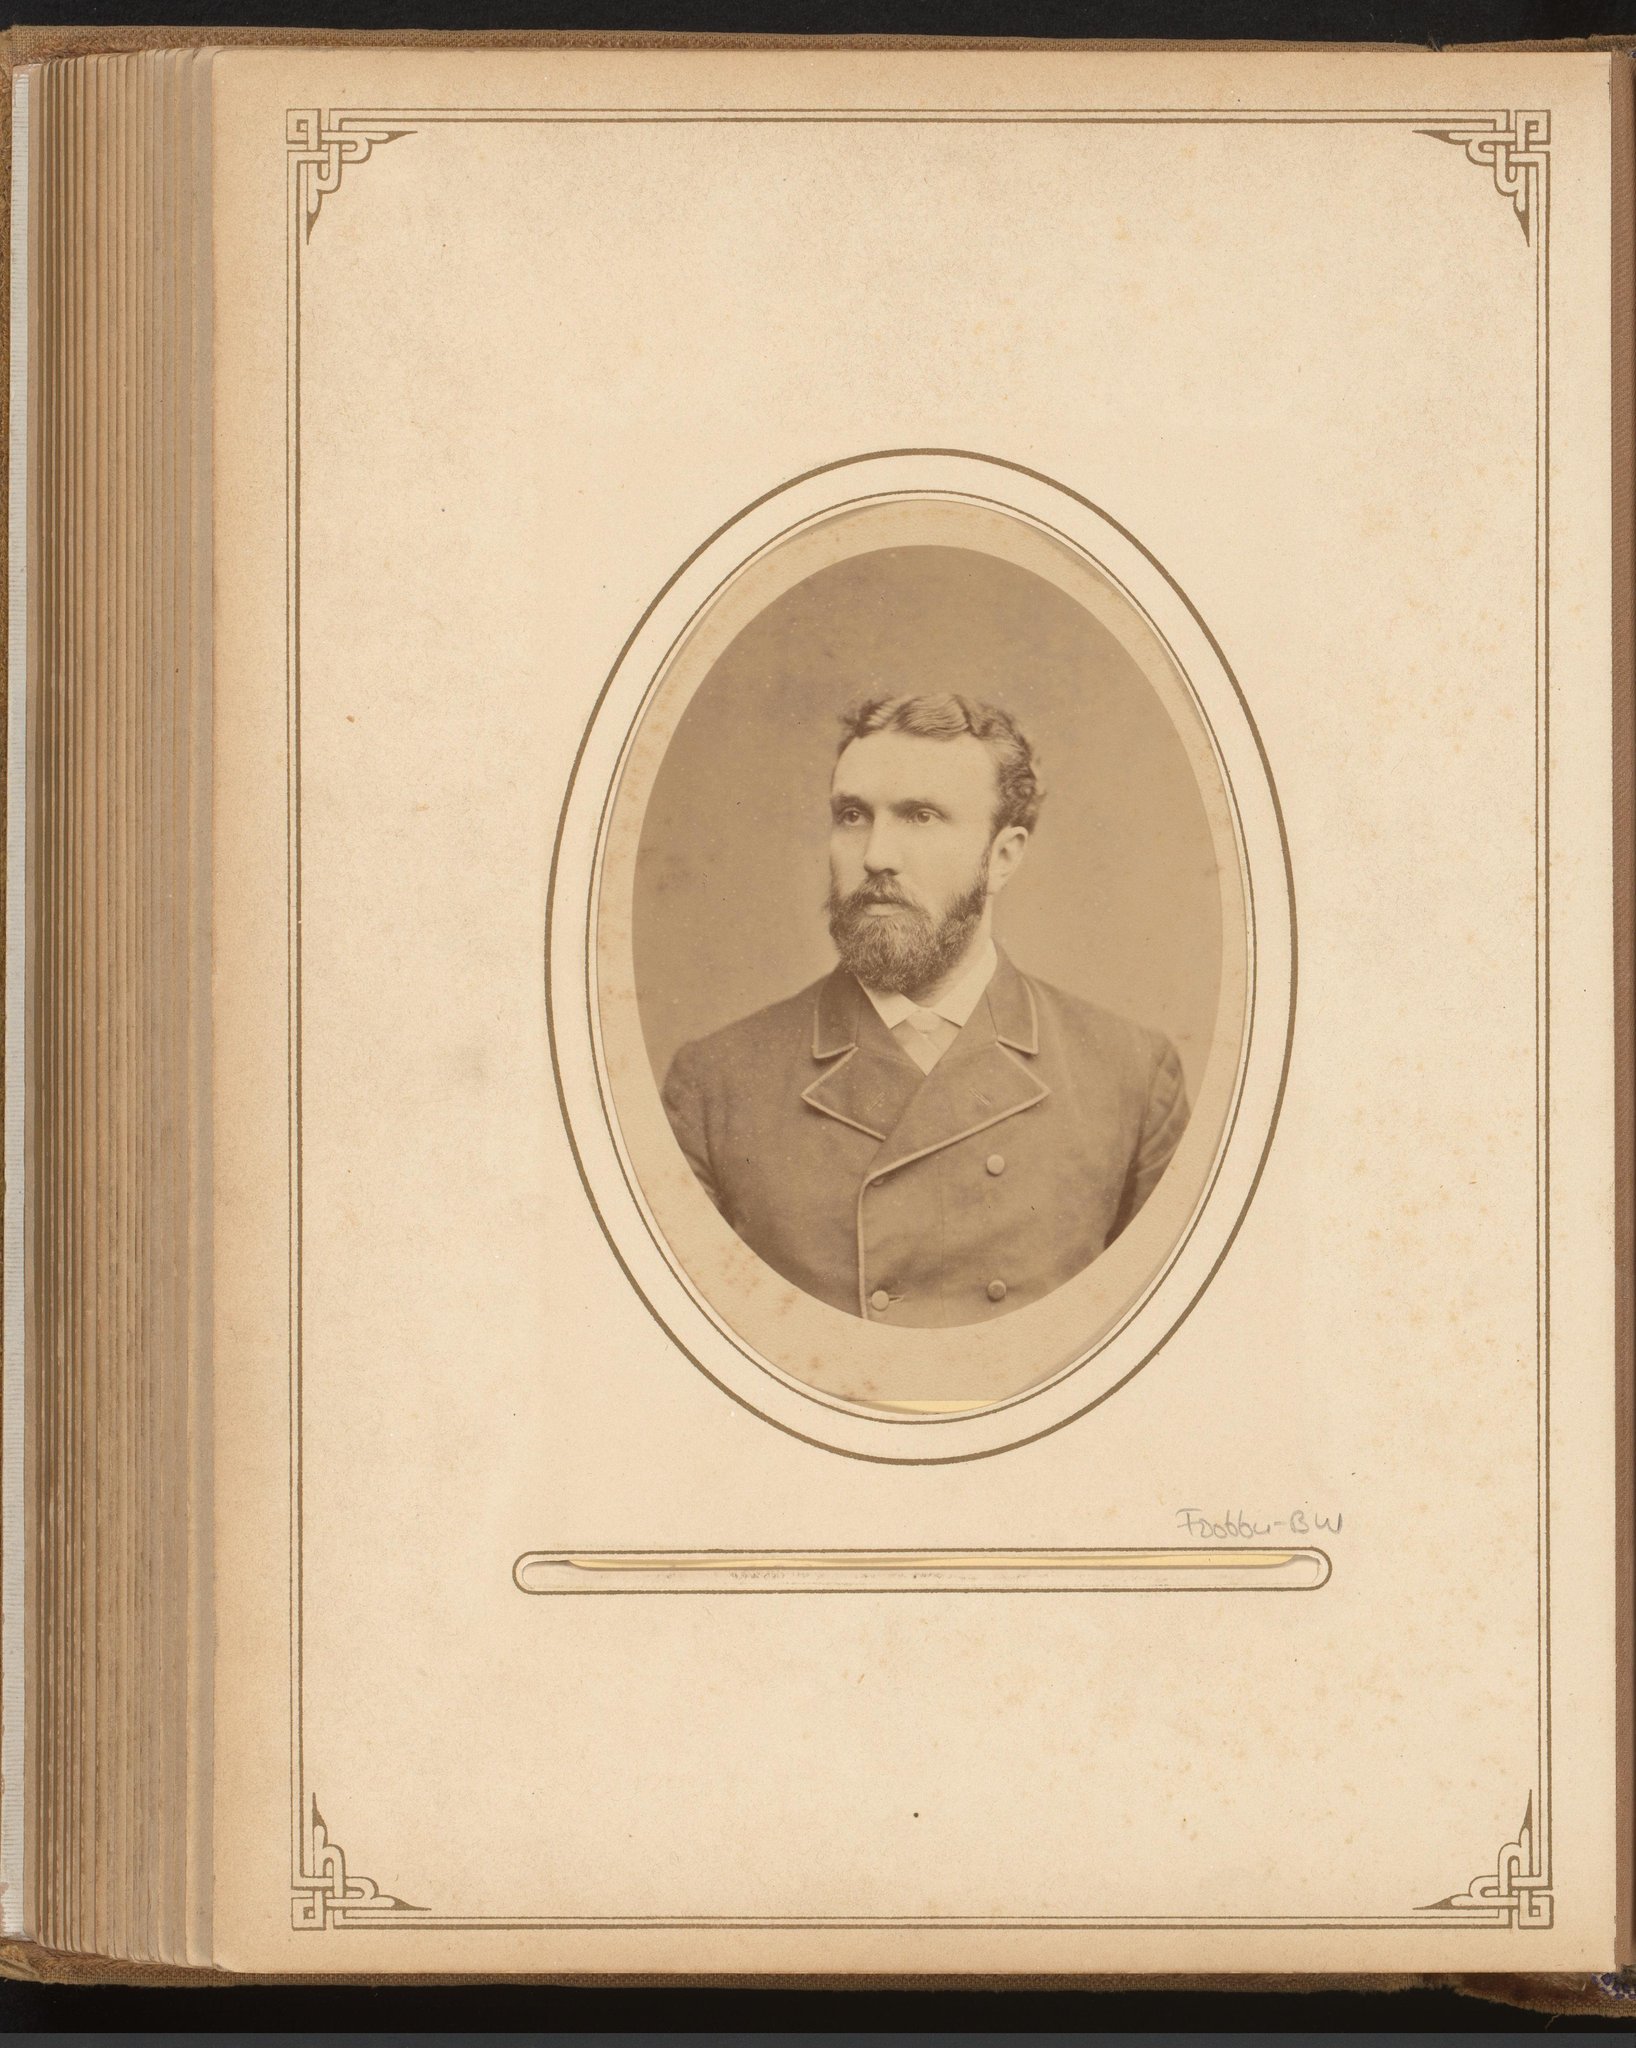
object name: photograph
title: Portret van een man met baard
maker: carel eduard westerborg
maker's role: fotograaf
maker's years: 1842-1916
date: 1861-1880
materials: cardboard, photographic support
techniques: albumen print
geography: arnhem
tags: historical persons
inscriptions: inscription: ‘Photographie van C.E. Westerborg/ Vossenstraat B.66/ Arnhem’